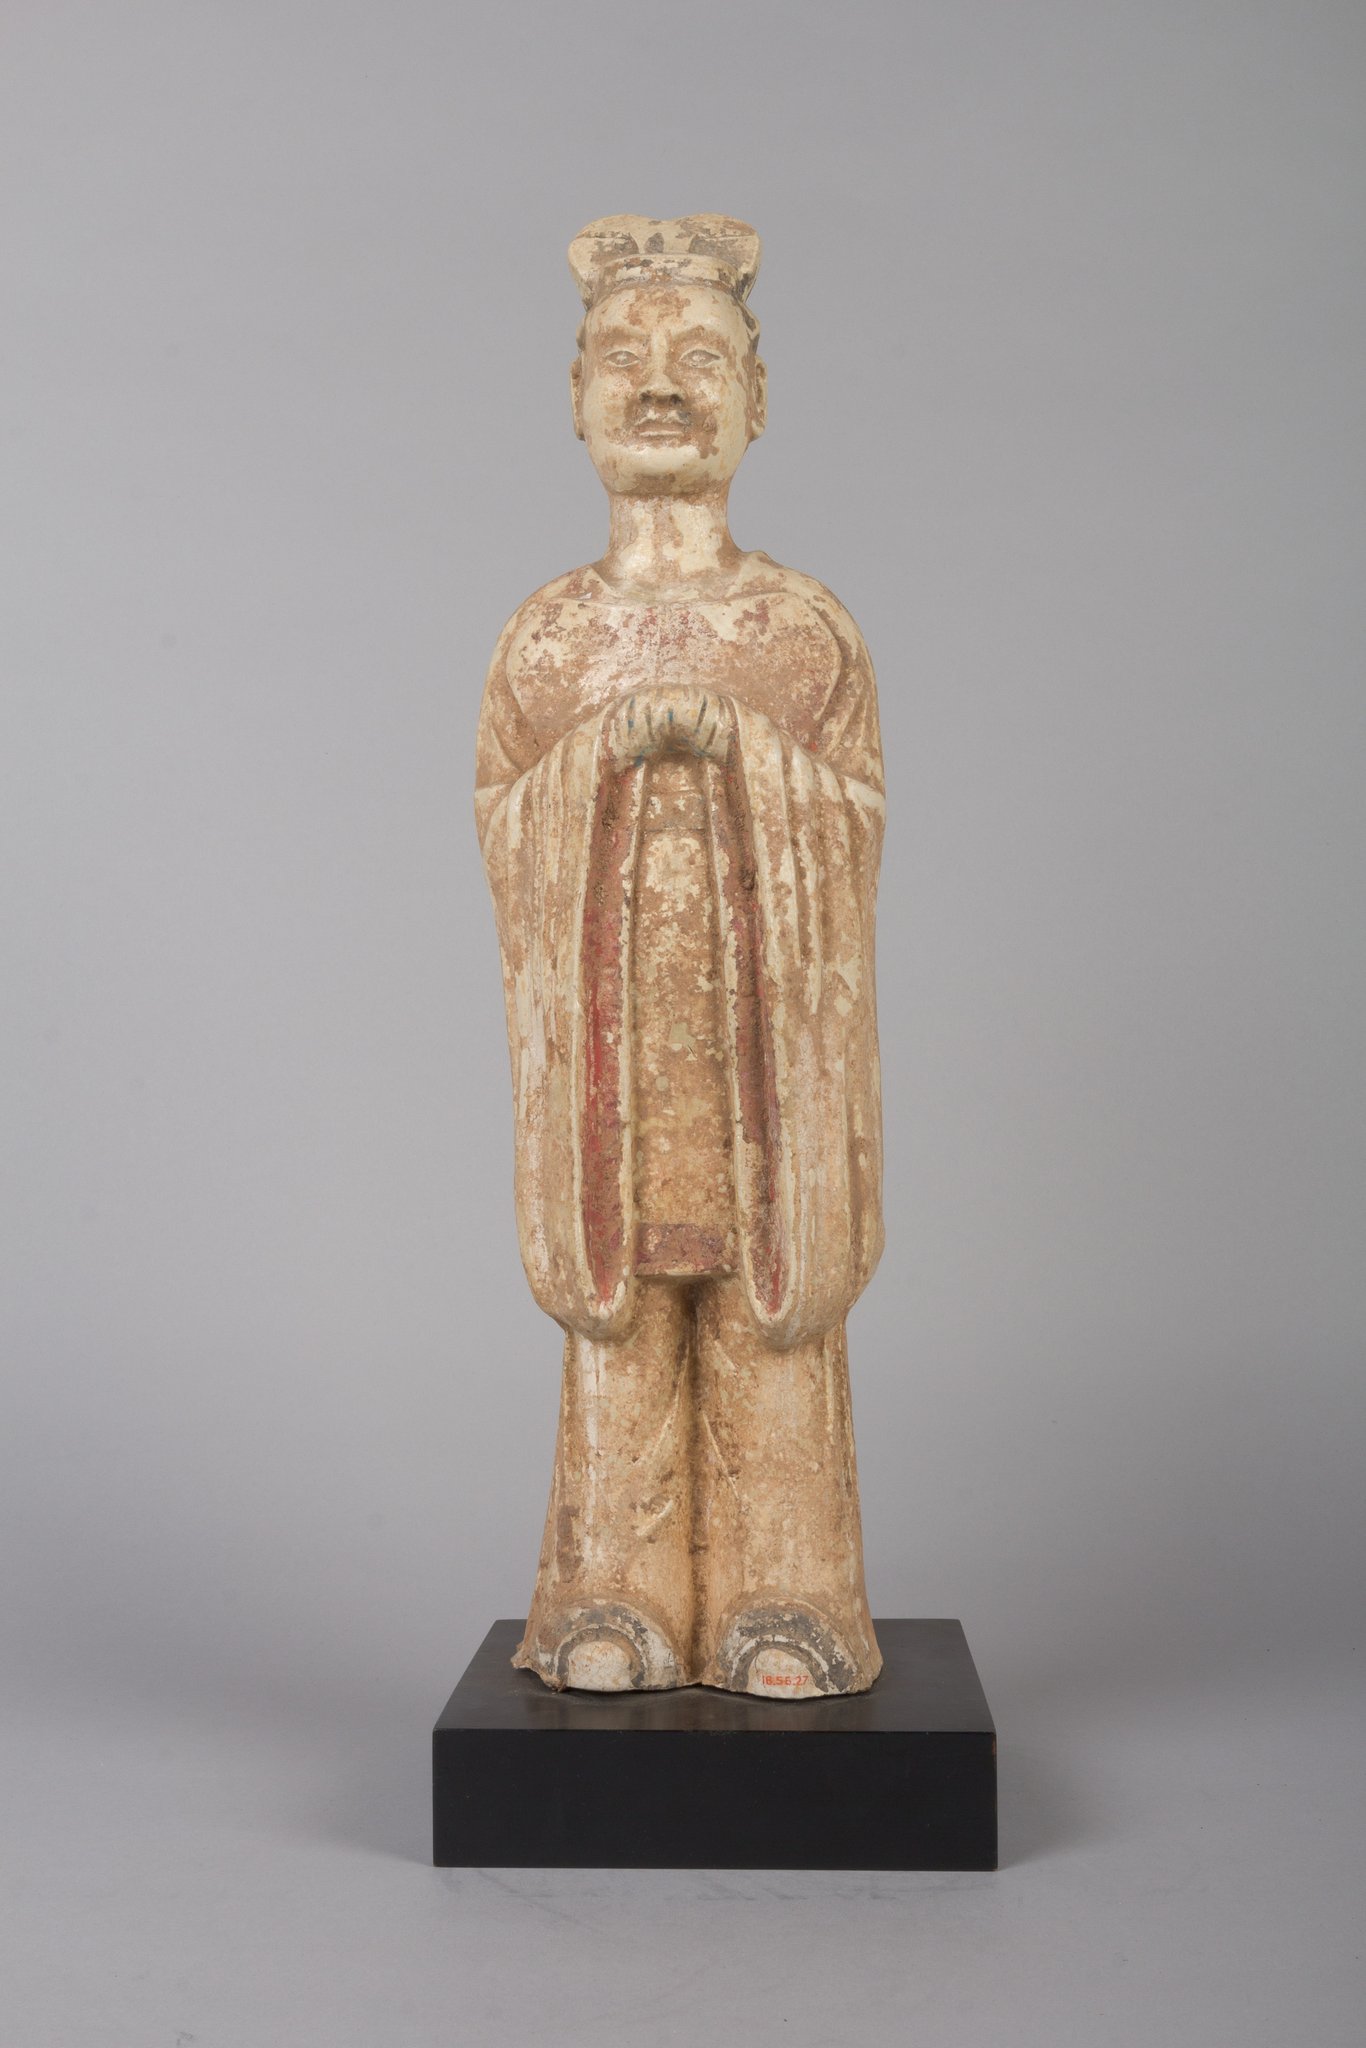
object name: figure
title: Figure of a Secretary or Official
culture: chinese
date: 618-907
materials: pottery